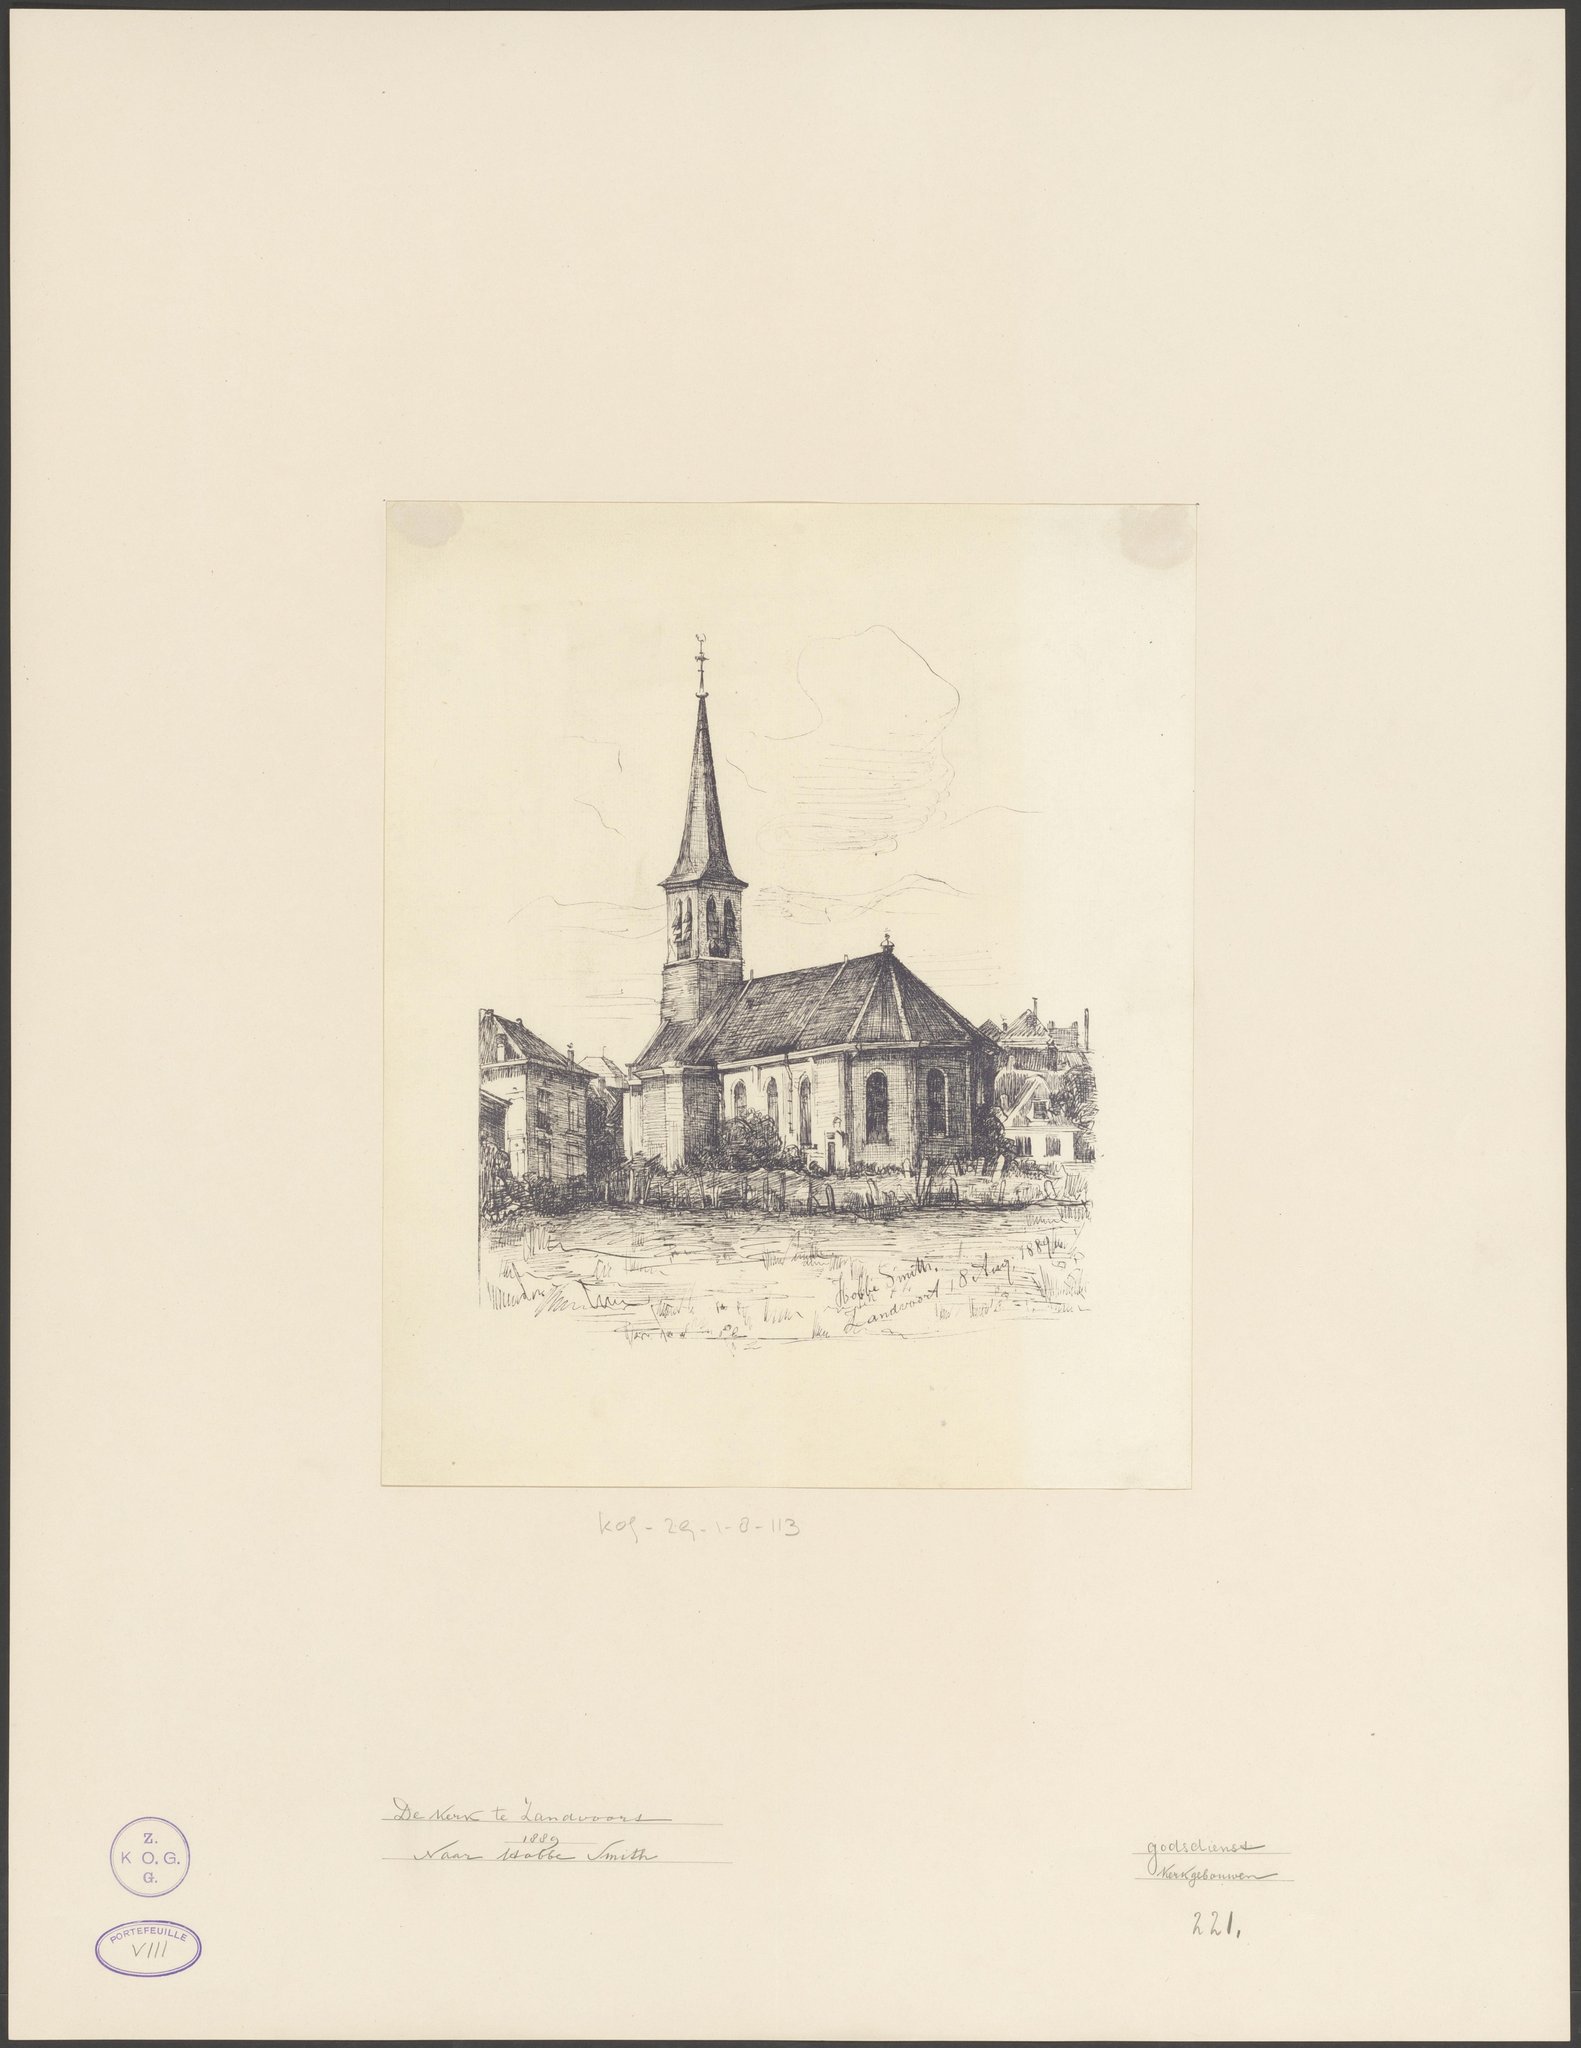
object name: fotomechanisch procedé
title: Kerk te Zandvoort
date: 1900-1950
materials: paper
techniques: photochemical processes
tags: church (exterior)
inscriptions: collector's mark: Lugt 1641, collector's mark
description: De Nederlands Hervormde dorpskerk te Zandvoort. Reproductie naar een tekening. Onderwerpsrubrieken binnen de Atlas Zeden en Gewoonten: Kerk en kerkwezen & Armwezen en liefdadige instellingen; Kerkgebouwen elders. V-Z.